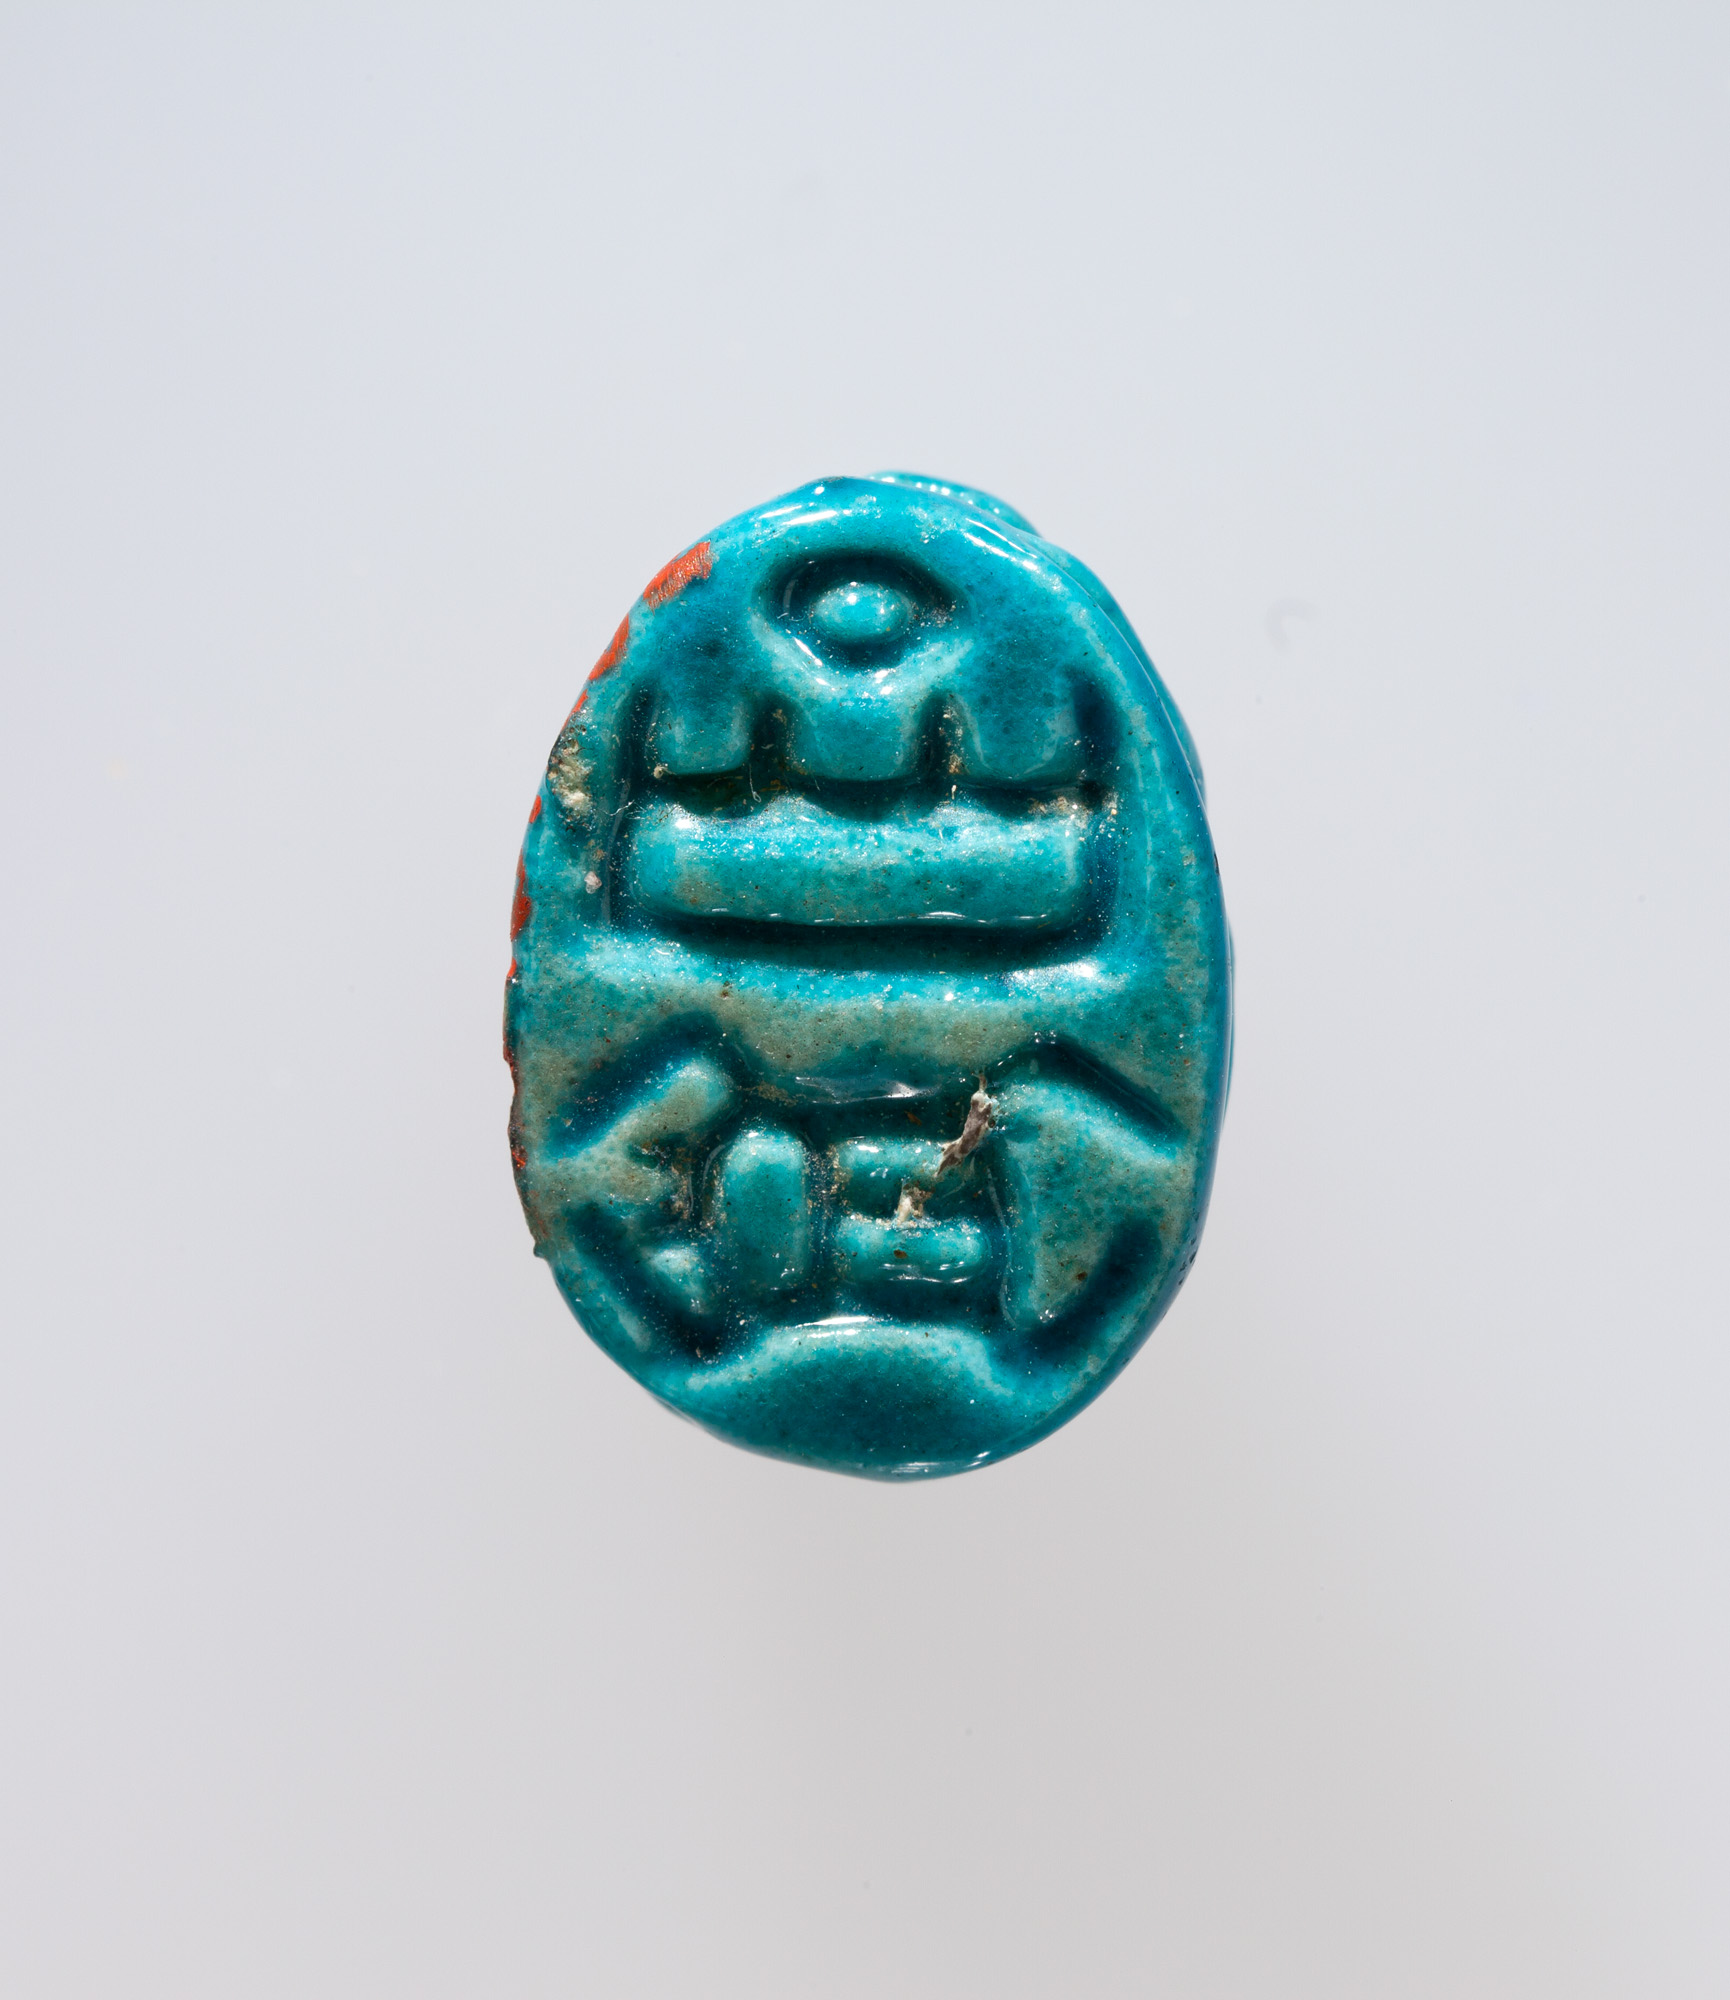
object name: scarab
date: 1479-1458 BCE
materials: stone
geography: egypt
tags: hieroglyphs,scarabs